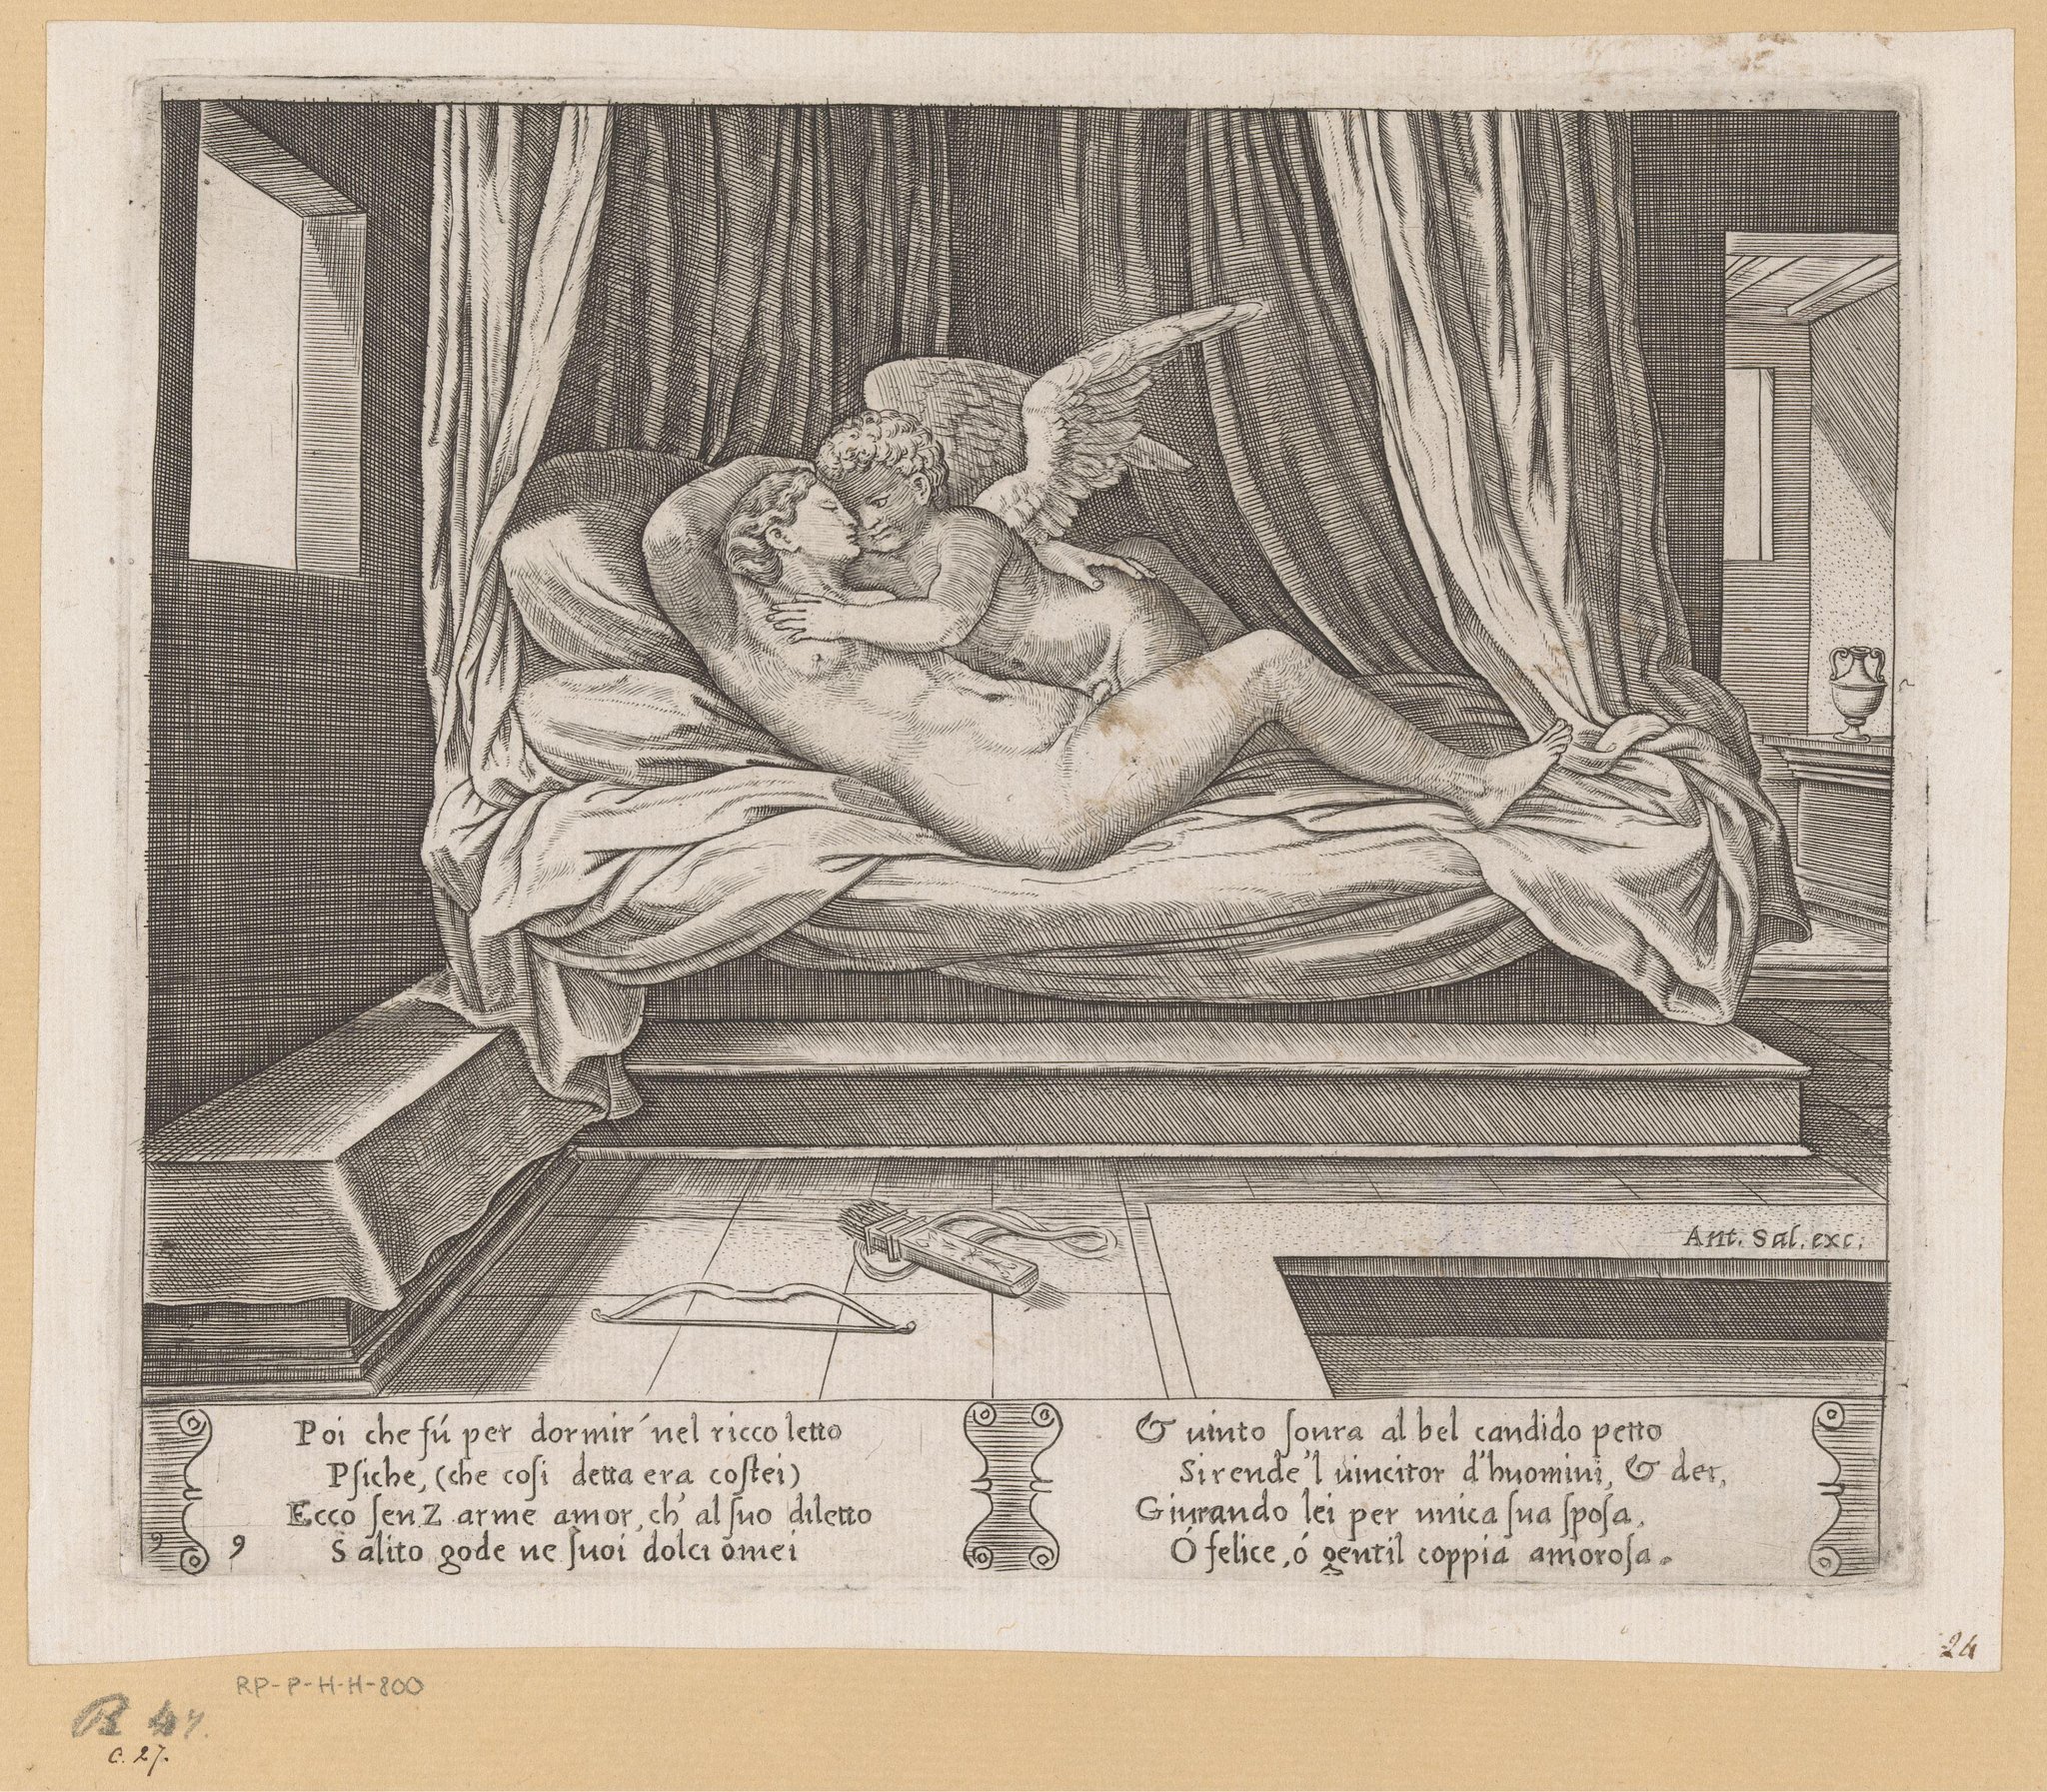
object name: print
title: Verhaal van Amor en Psyche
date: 1530-1560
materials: paper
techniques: engraving, intaglio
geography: rome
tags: cupid and psyche as lovers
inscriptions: collector's mark: Lugt 11, number: ‘24’, collector's mark: Lugt 10, collector's mark: ‘Hinloopen’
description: Amor en Psyche op bed als geliefden. Links een open raam en op de voorgrond de boog en pijlenkoker van Amor. Italiaanse tekst in twee cartouches in ondermarge. Tweemaal genummerd linksonder: 9.